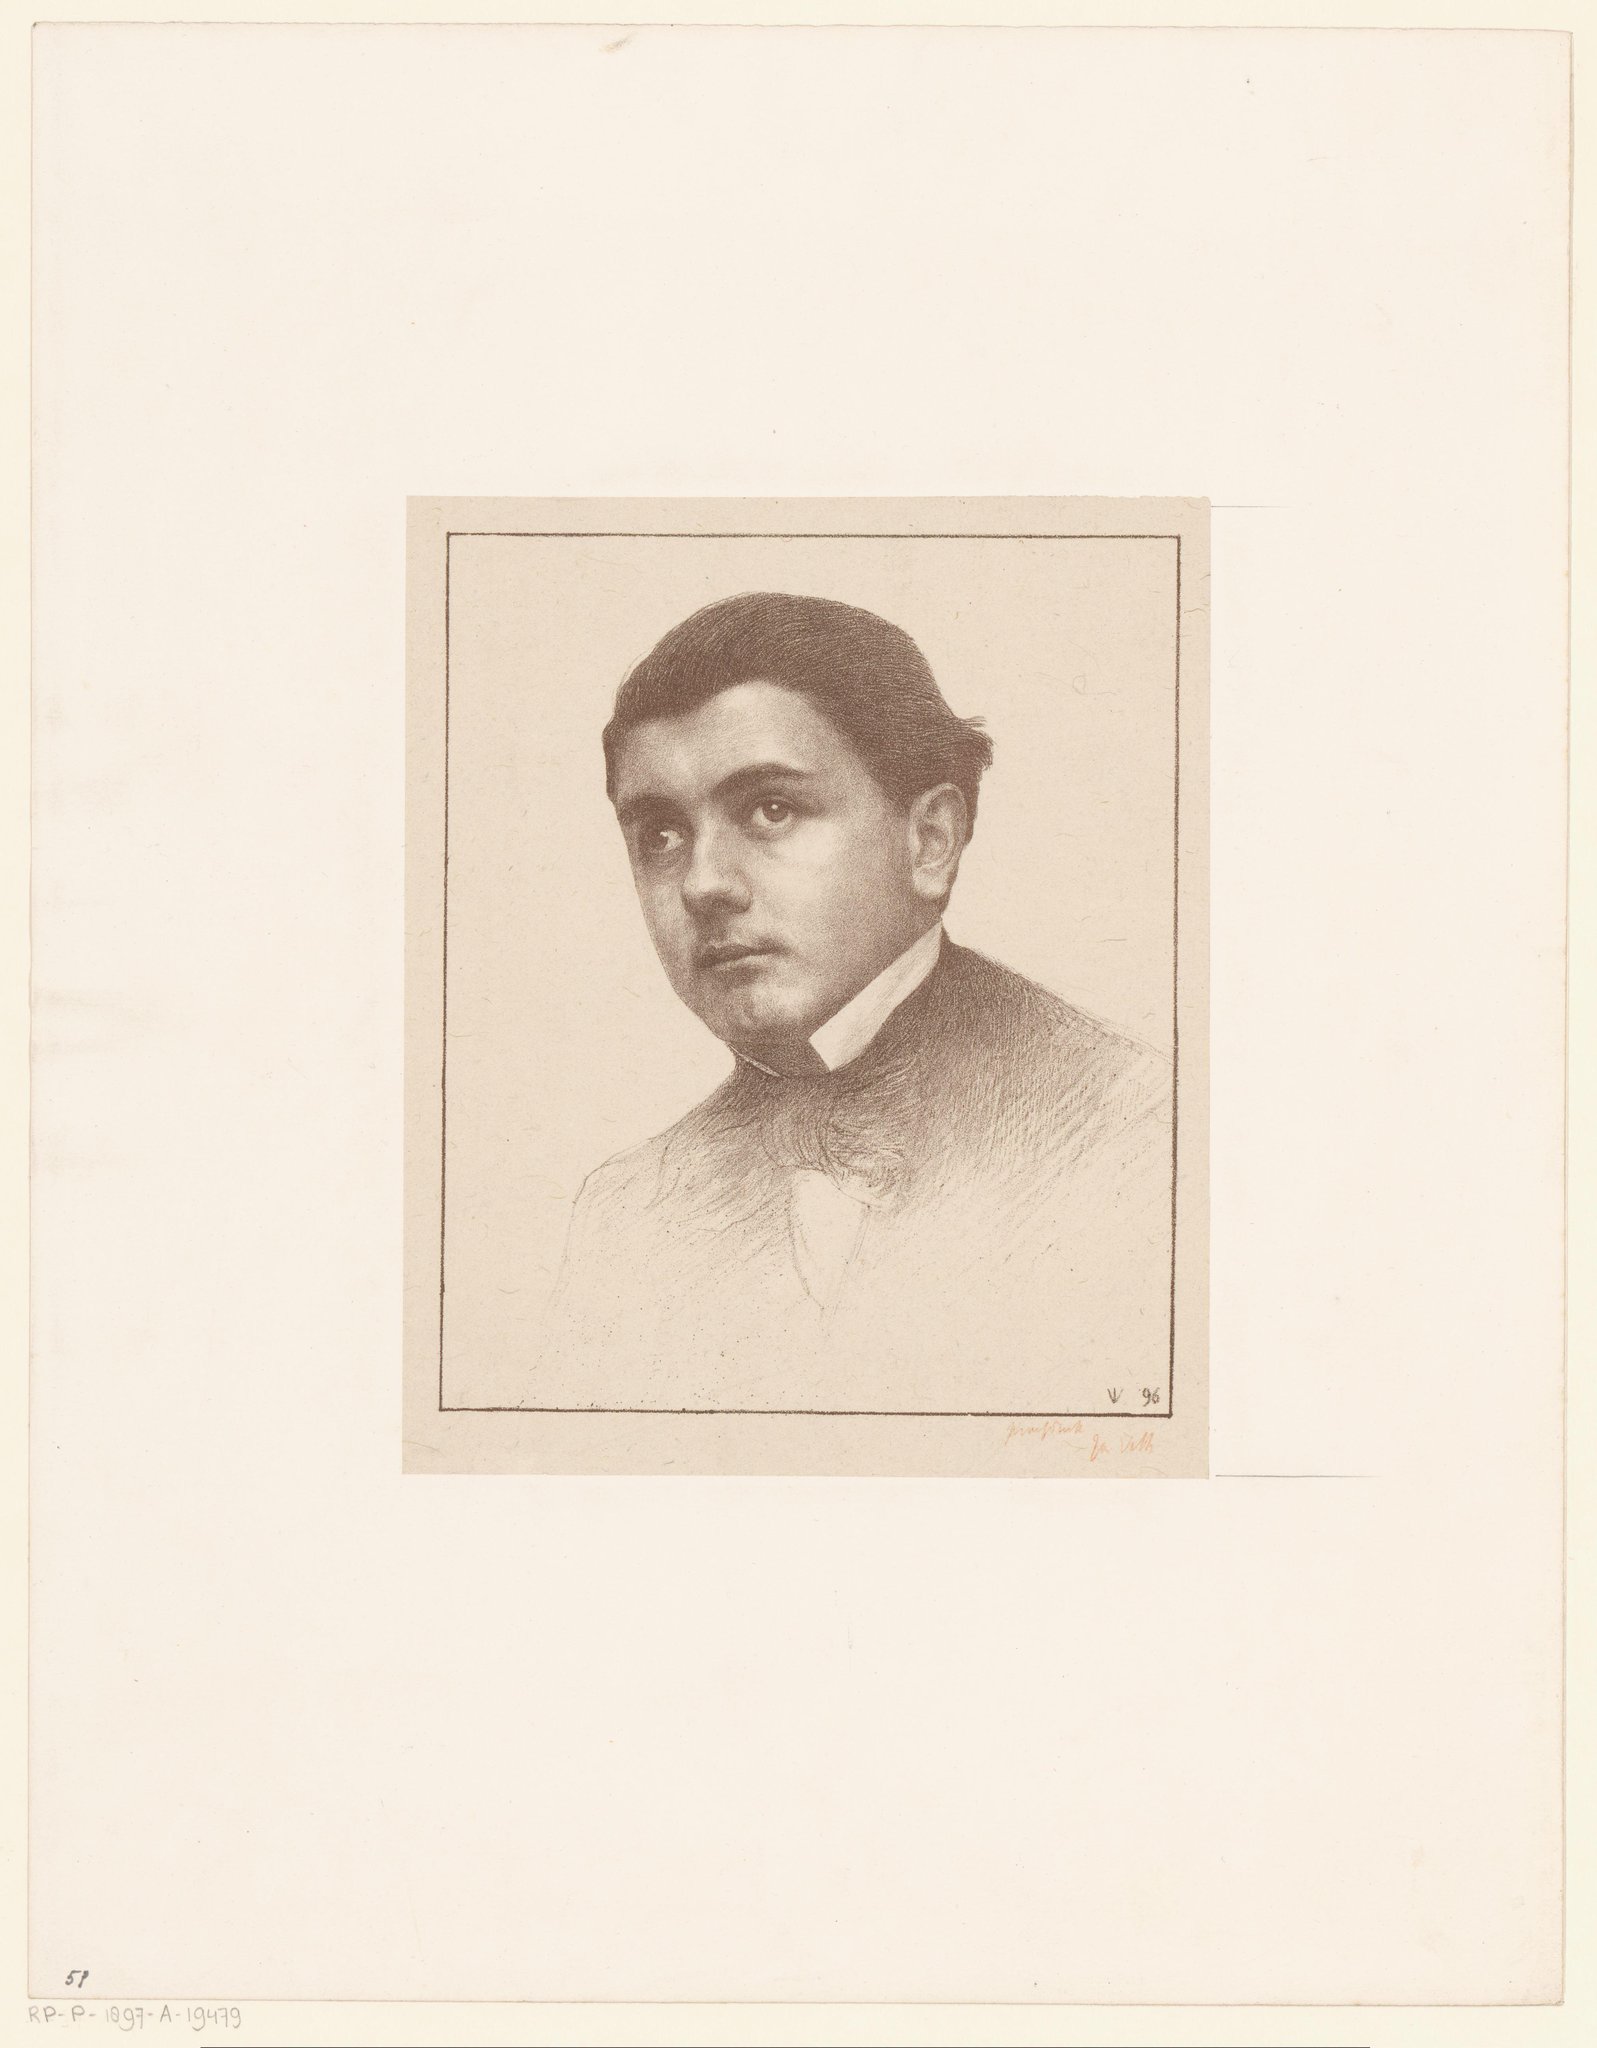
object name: print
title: Portretten van De Kroniek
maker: jan veth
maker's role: designer, draughtsman, painter, print maker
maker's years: 1864-1925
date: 1896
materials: paper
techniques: lithograph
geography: netherlands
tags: amsterdam, allard pierson, historical persons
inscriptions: inscription: ‘proefdruk / Jan Veth’, collector's mark: Lugt 2228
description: Dit portret werd uitgegeven als bijvoegsel bij De Kroniek op 7 juni 1896.